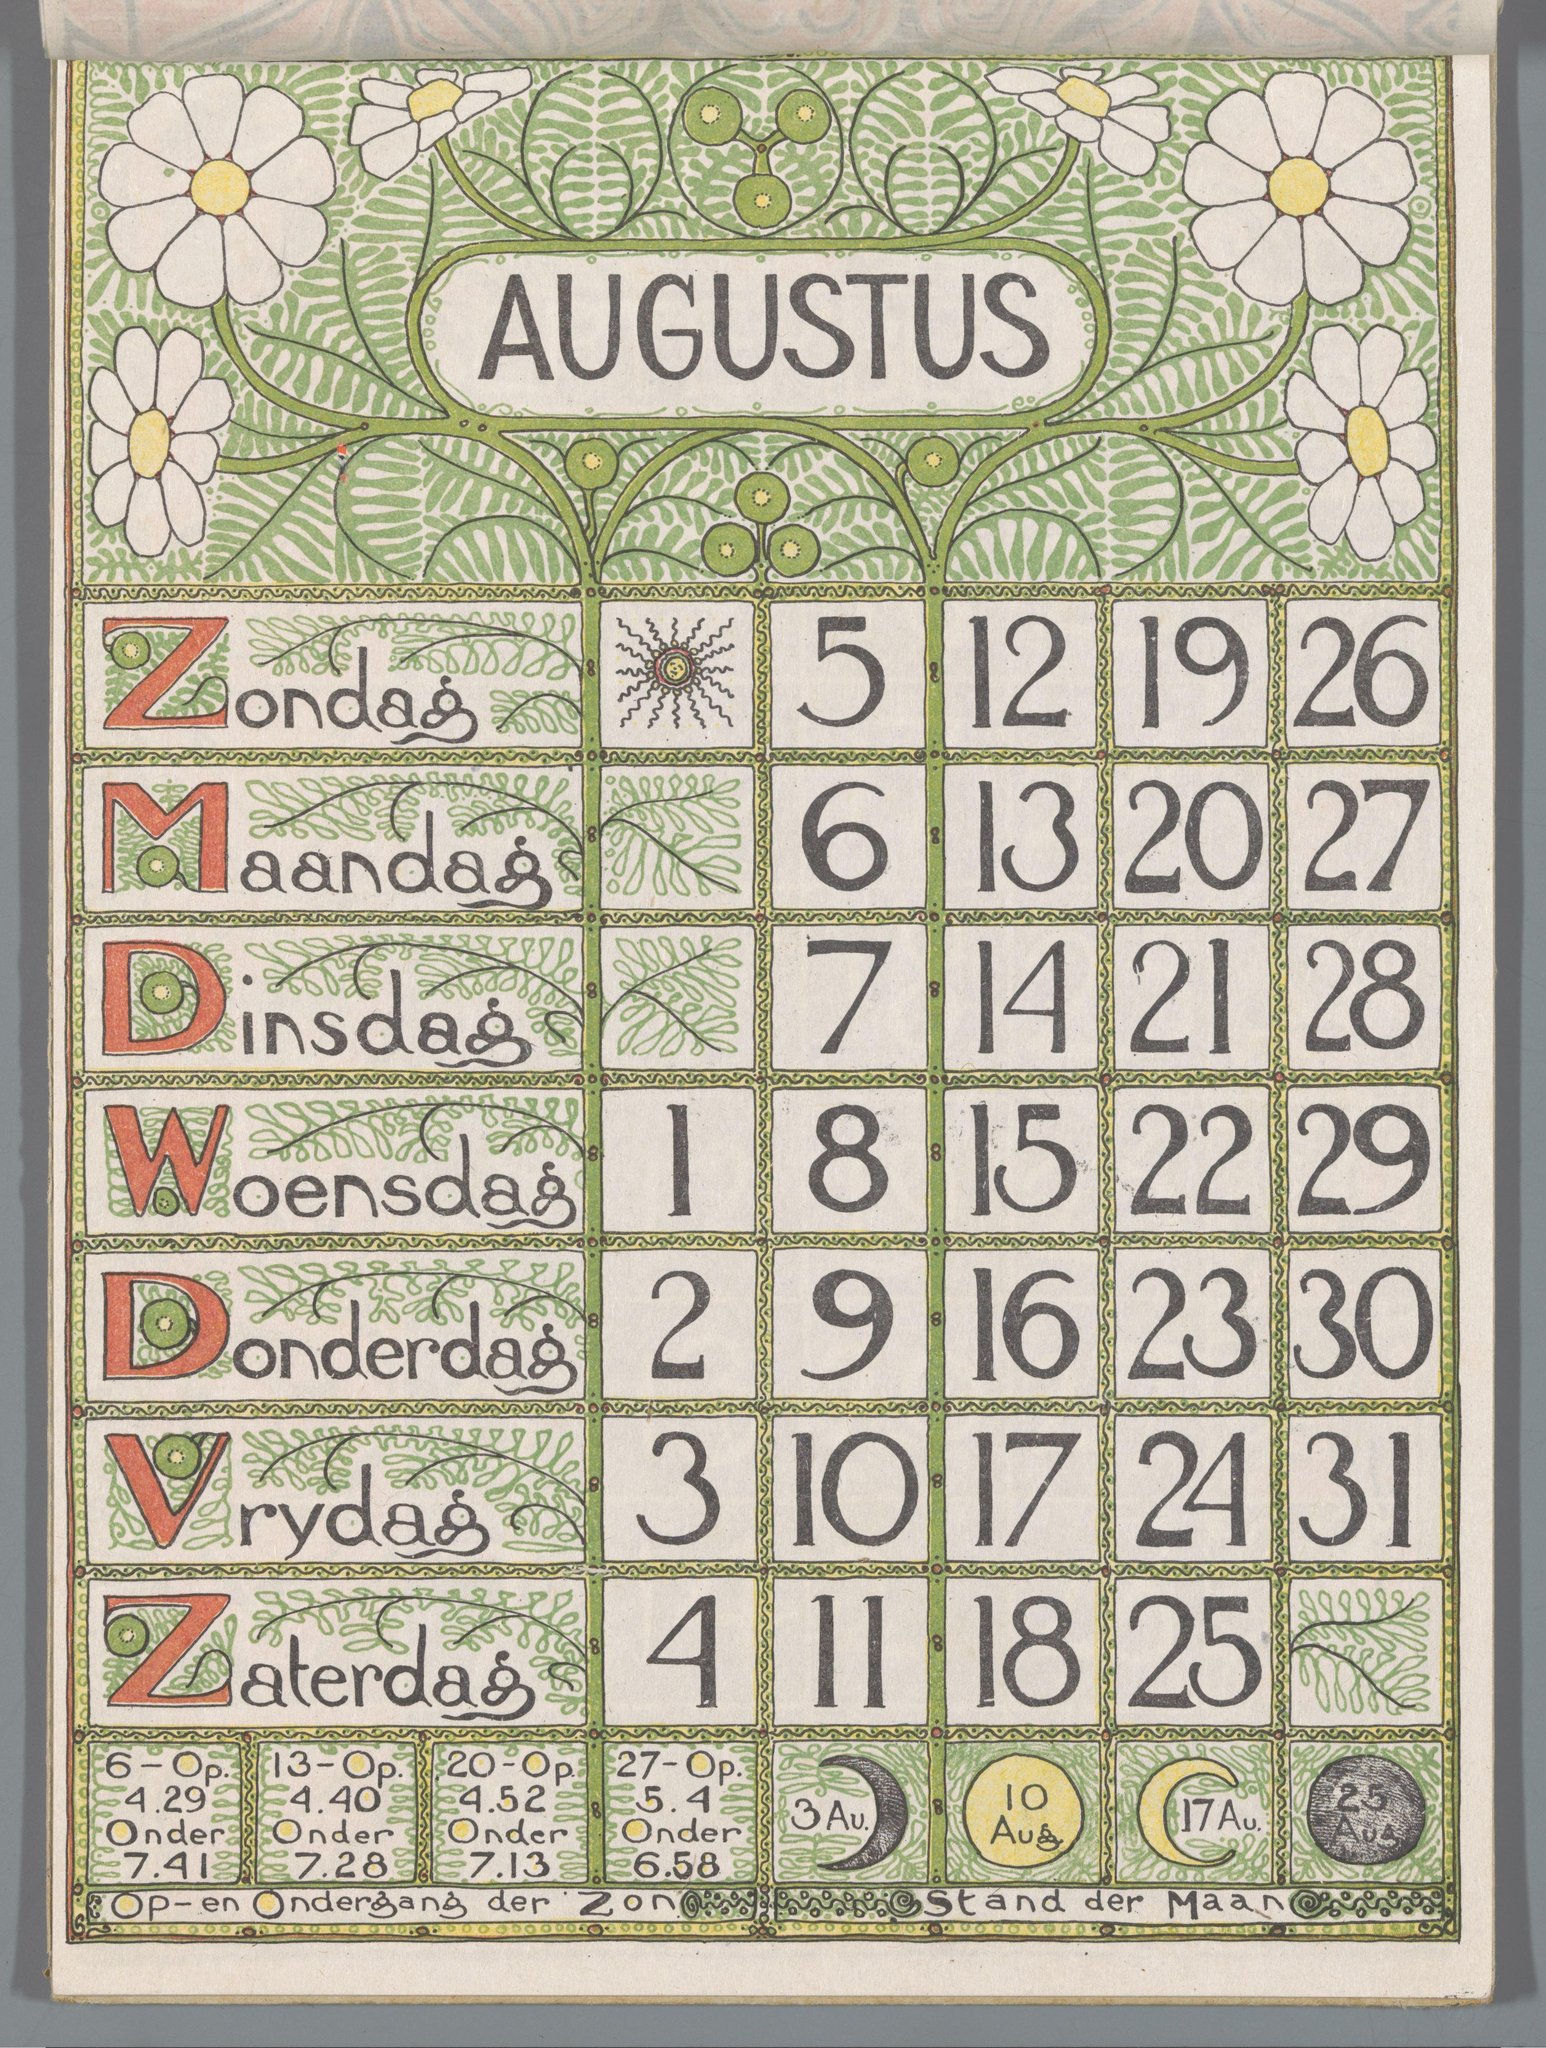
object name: print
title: Kalenderblad augustus 1900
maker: theo nieuwenhuis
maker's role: designer, draughtsman, print maker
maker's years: 1866-1951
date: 1900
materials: paper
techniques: lithograph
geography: amsterdam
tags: august ~ other concepts